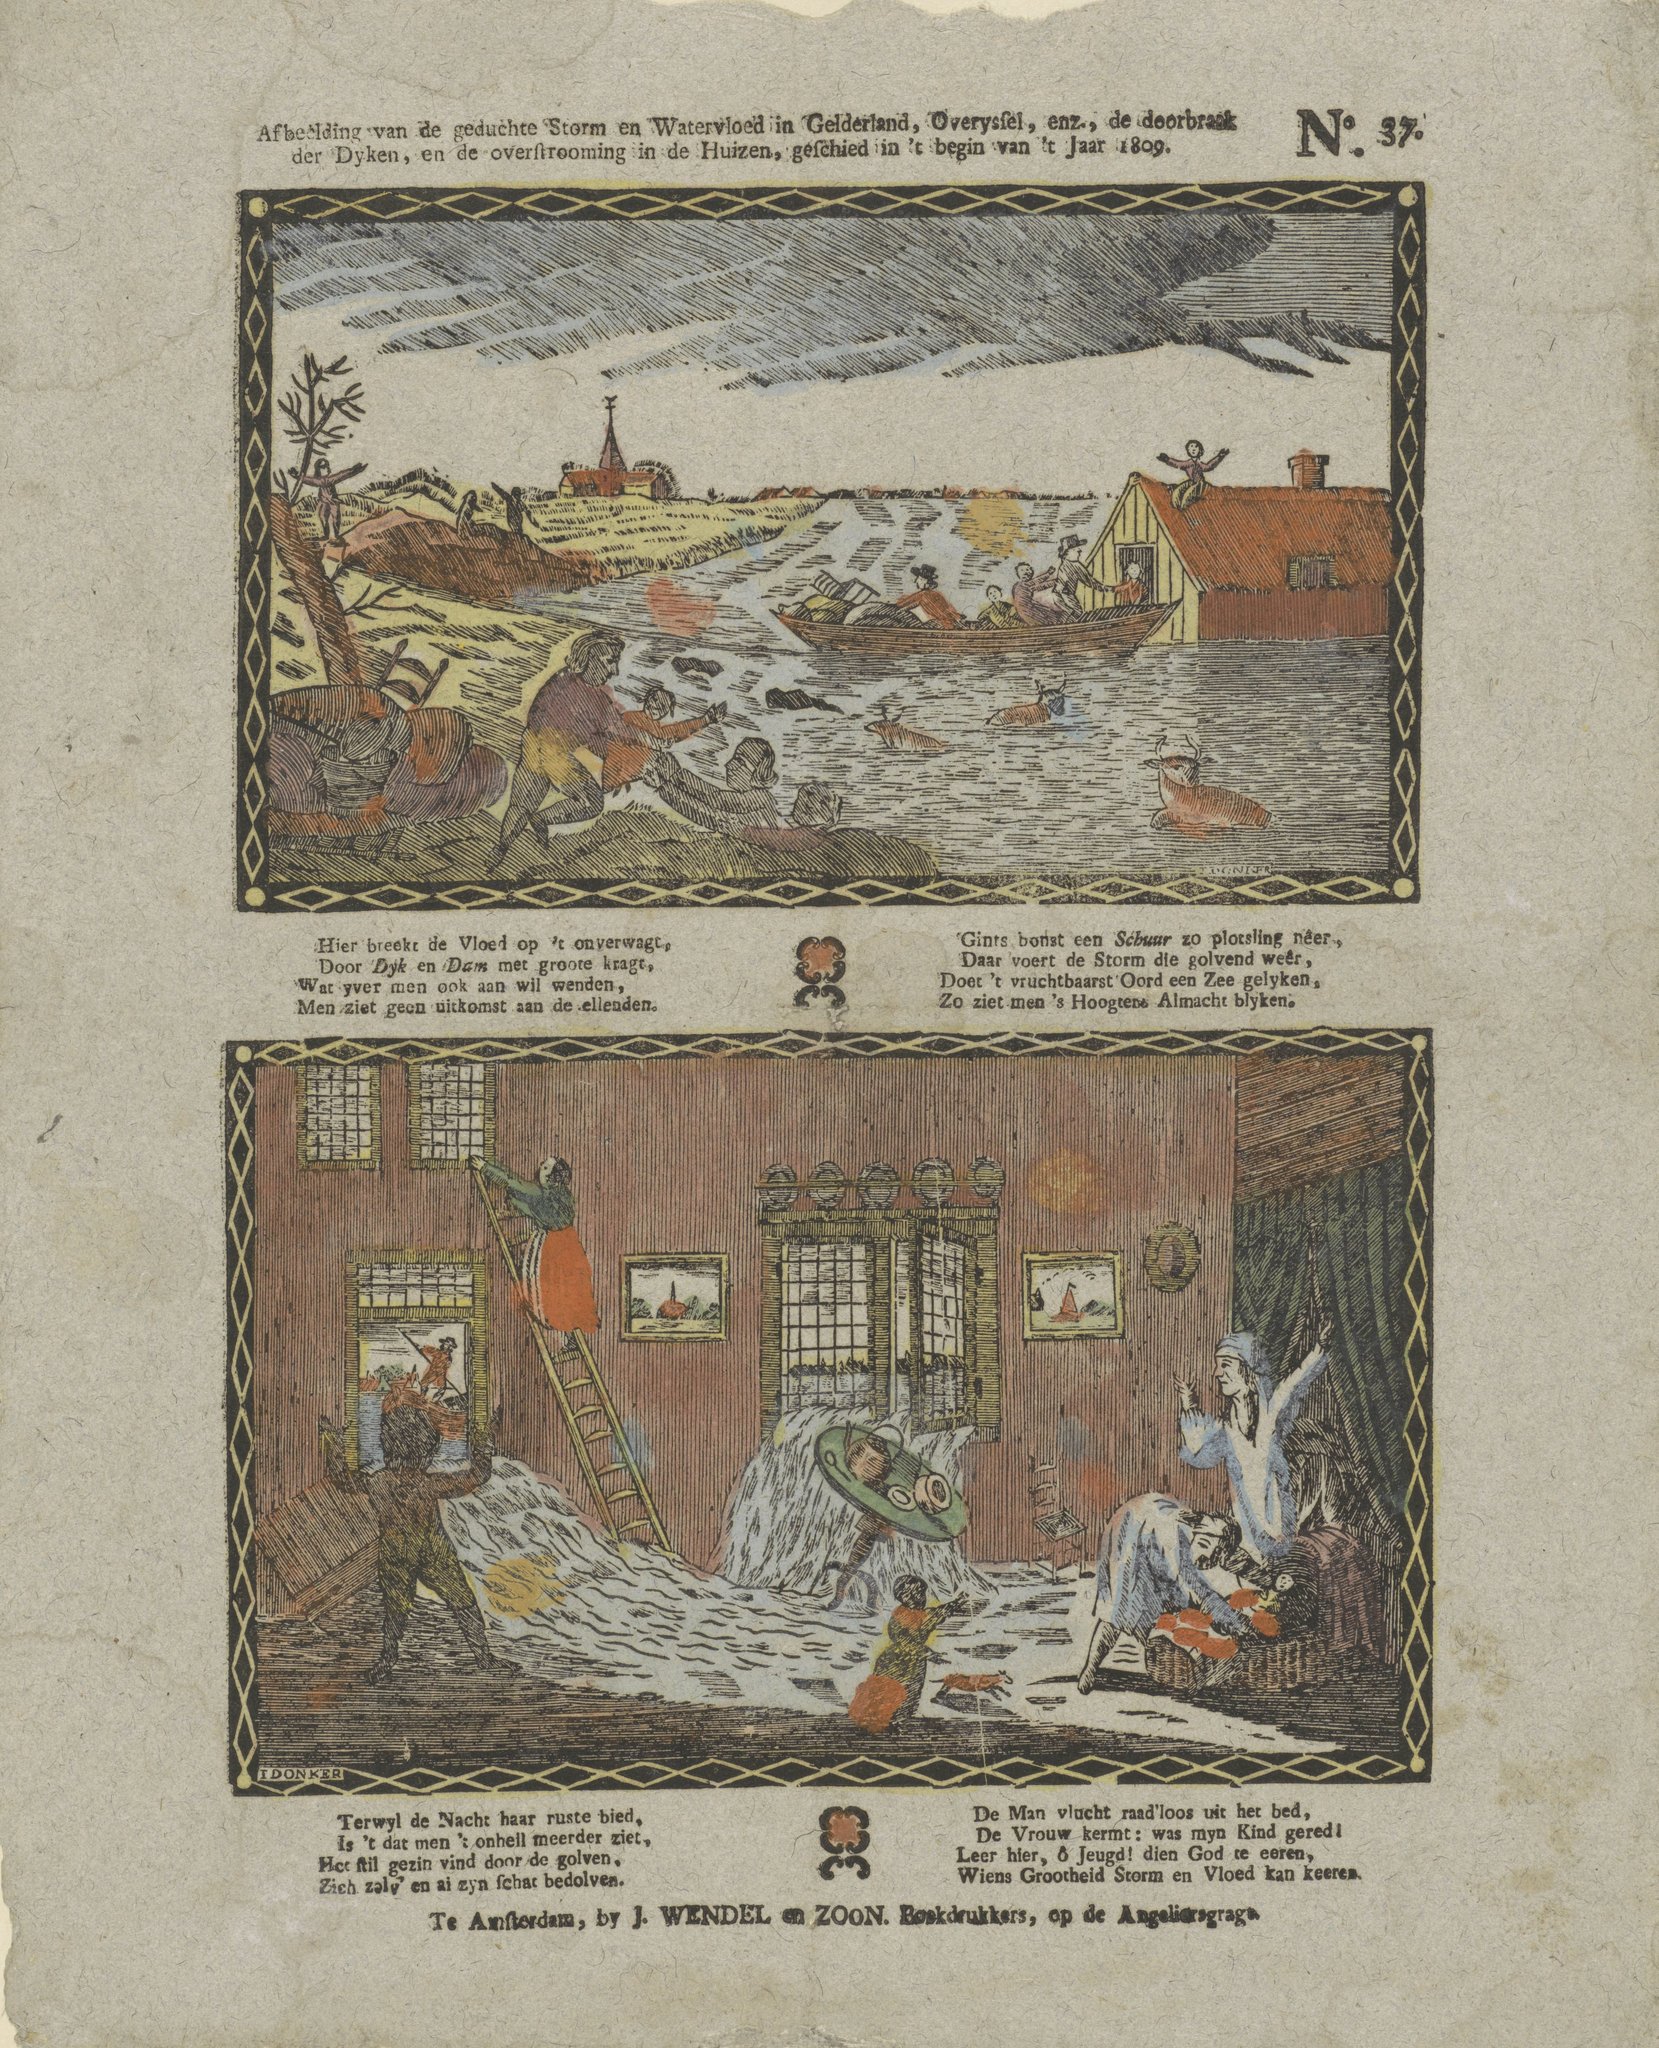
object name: print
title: Afbeelding van de geduchte storm en watervloed in Gelderland, Overussel, enz., de doorbraak / der Dyken, en de overstrooming in de huizen, geschied in 't begin van 't jaar 1809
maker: johannes donker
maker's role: draughtsman, print maker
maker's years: 1795-1869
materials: paper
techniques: colour, letterpress printing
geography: netherlands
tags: rescue work during a flood, dike-break, flood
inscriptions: collector's mark: Lugt 2760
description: Blad met 2 voorstellingen van de watervloed in Gelderland en Overysel in 1809. Boven: een onder water gelopen landschap, waar mensen van het dak van hun huis worden gered. Onder: een zicht in een interieur waar water door de ramen naar binnen stroomt. Onder elke afbeelding een achtregelig vers in twee kolommen. Genummerd rechtsboven: No. 37.